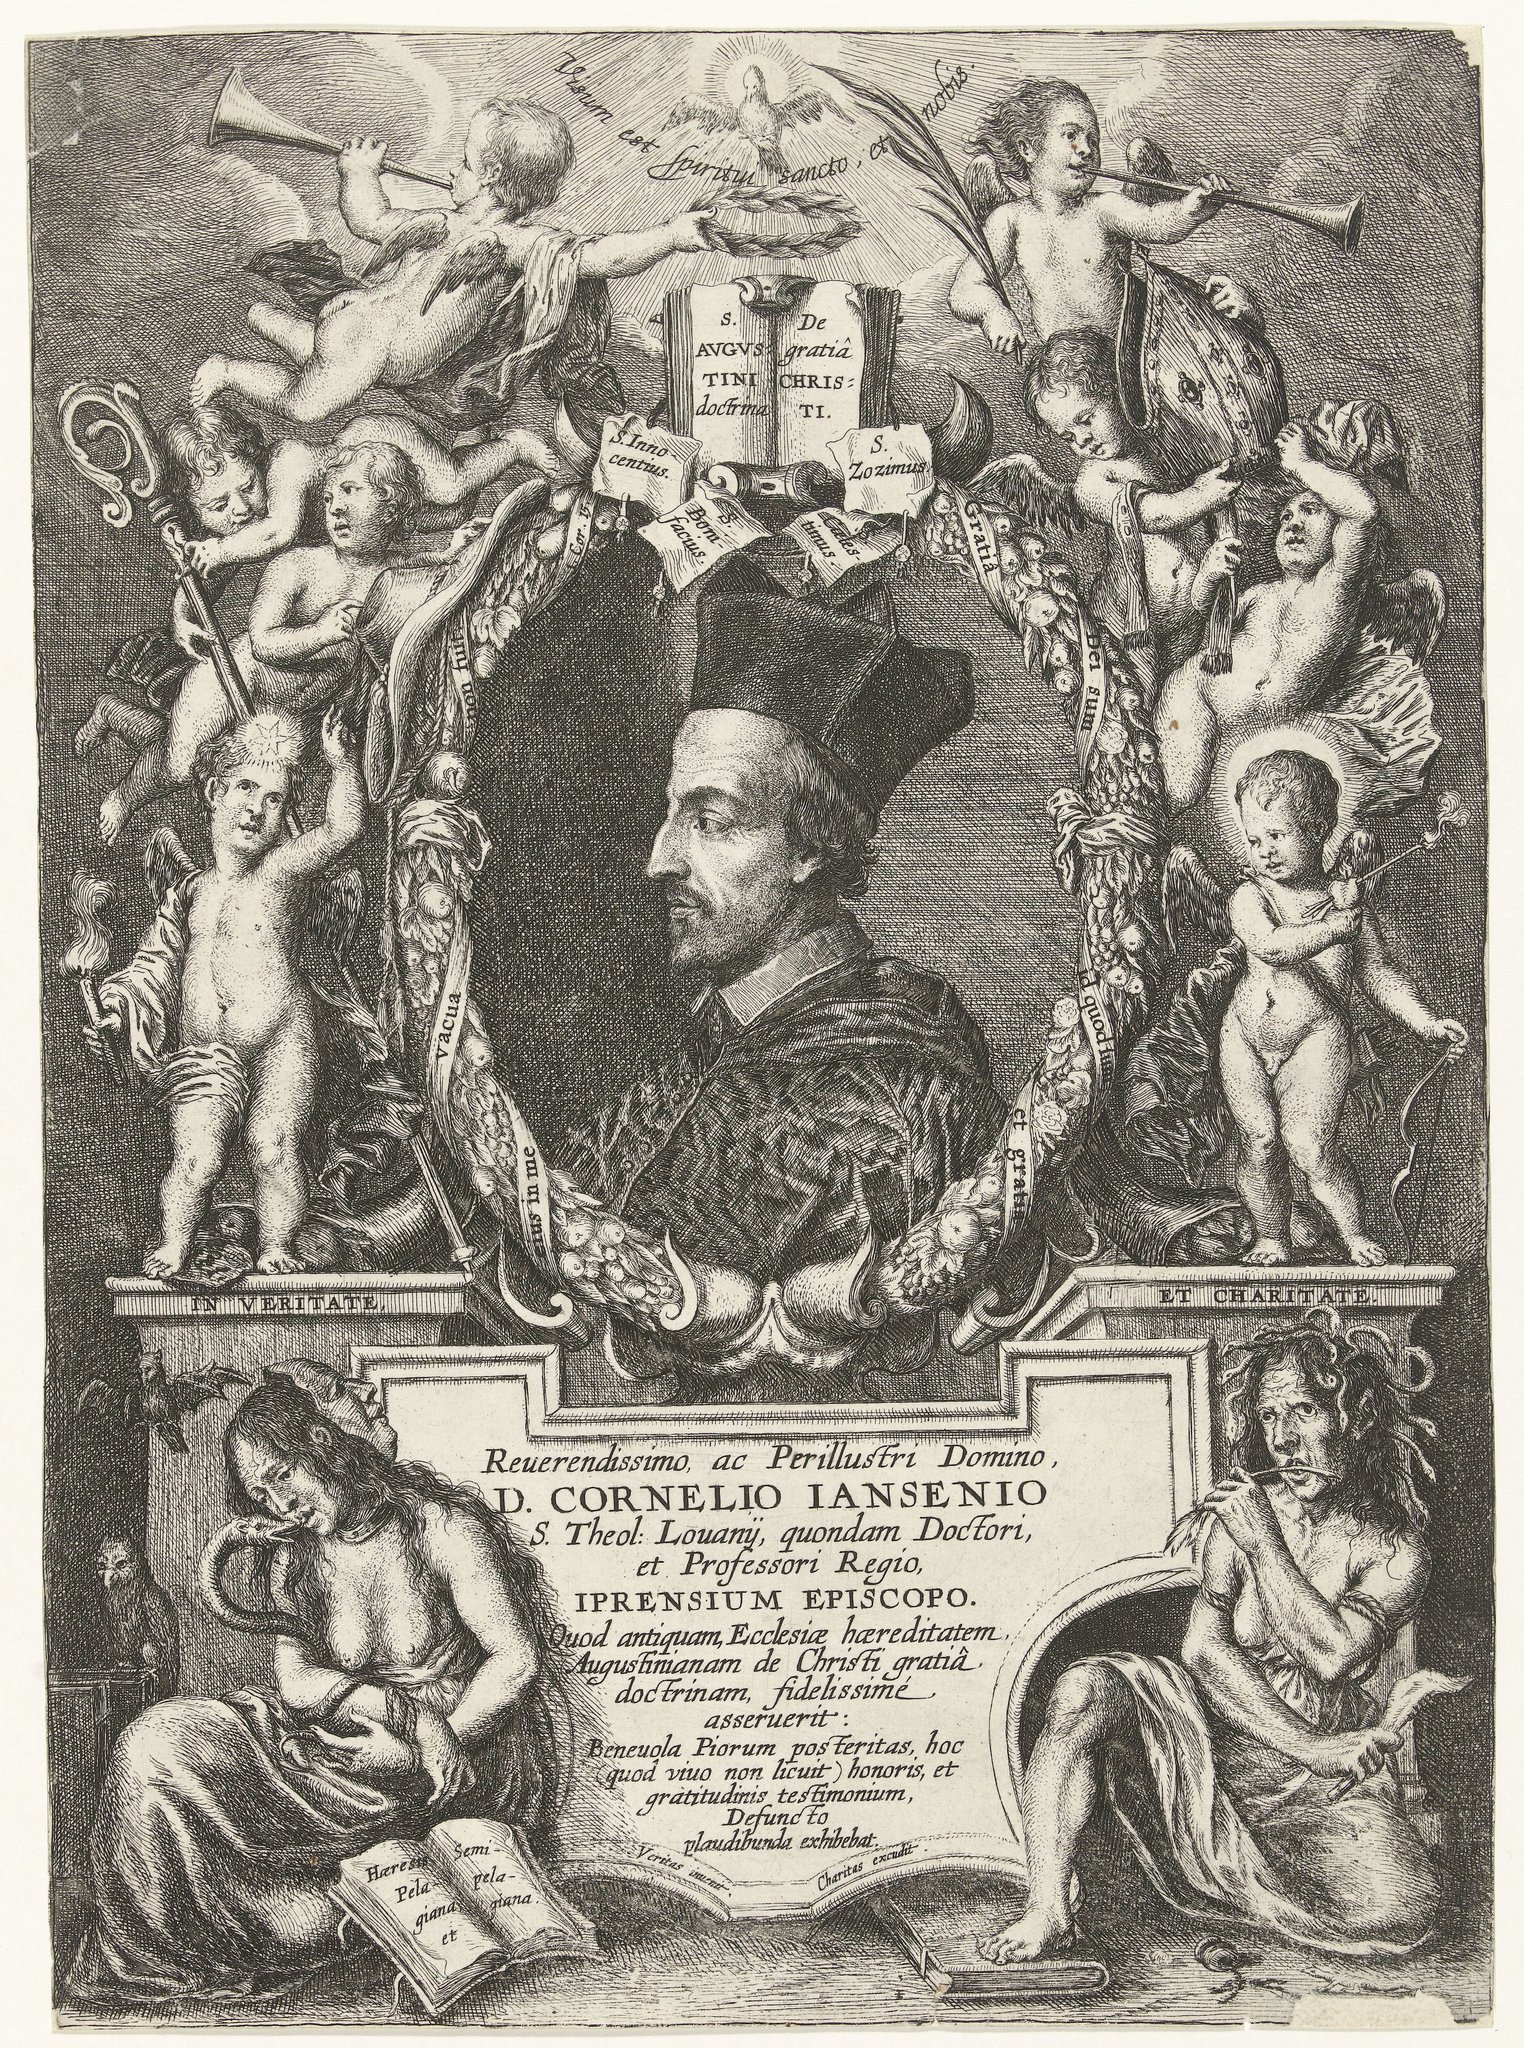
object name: print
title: Portret van Cornelis Jansenius, bisschop van Yperen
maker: philip fruytiers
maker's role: print maker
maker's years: 1610-1666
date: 1620-1666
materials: paper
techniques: etching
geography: antwerp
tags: cornelius jansenius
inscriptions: collector's mark: Lugt 2228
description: Portretbuste in ovaal naar links van Cornelis Jansenius, bisschop van Yperen. Het hoofd is en profil weergegeven en getooid met een bisschopsmuts. Het portret is gevat in een ovale krans van bladeren, vruchten en linten en wordt omgeven door acht putti met verschillende attibuten. De twee putti bovenin blazen de bazuin en houden een lauwerkrans en een palmtak vast. Tussen hen in vliegt een duif, symbool van de Heilige Geest. Het ovaal staat op een sokkel waarop de naam en titels van de geportrettreerde staan, gevolgd door een tekst in het Latijn. Voor de sokkel zit links de personificatie van Bedrog en rechts de personificatie van Nijd.